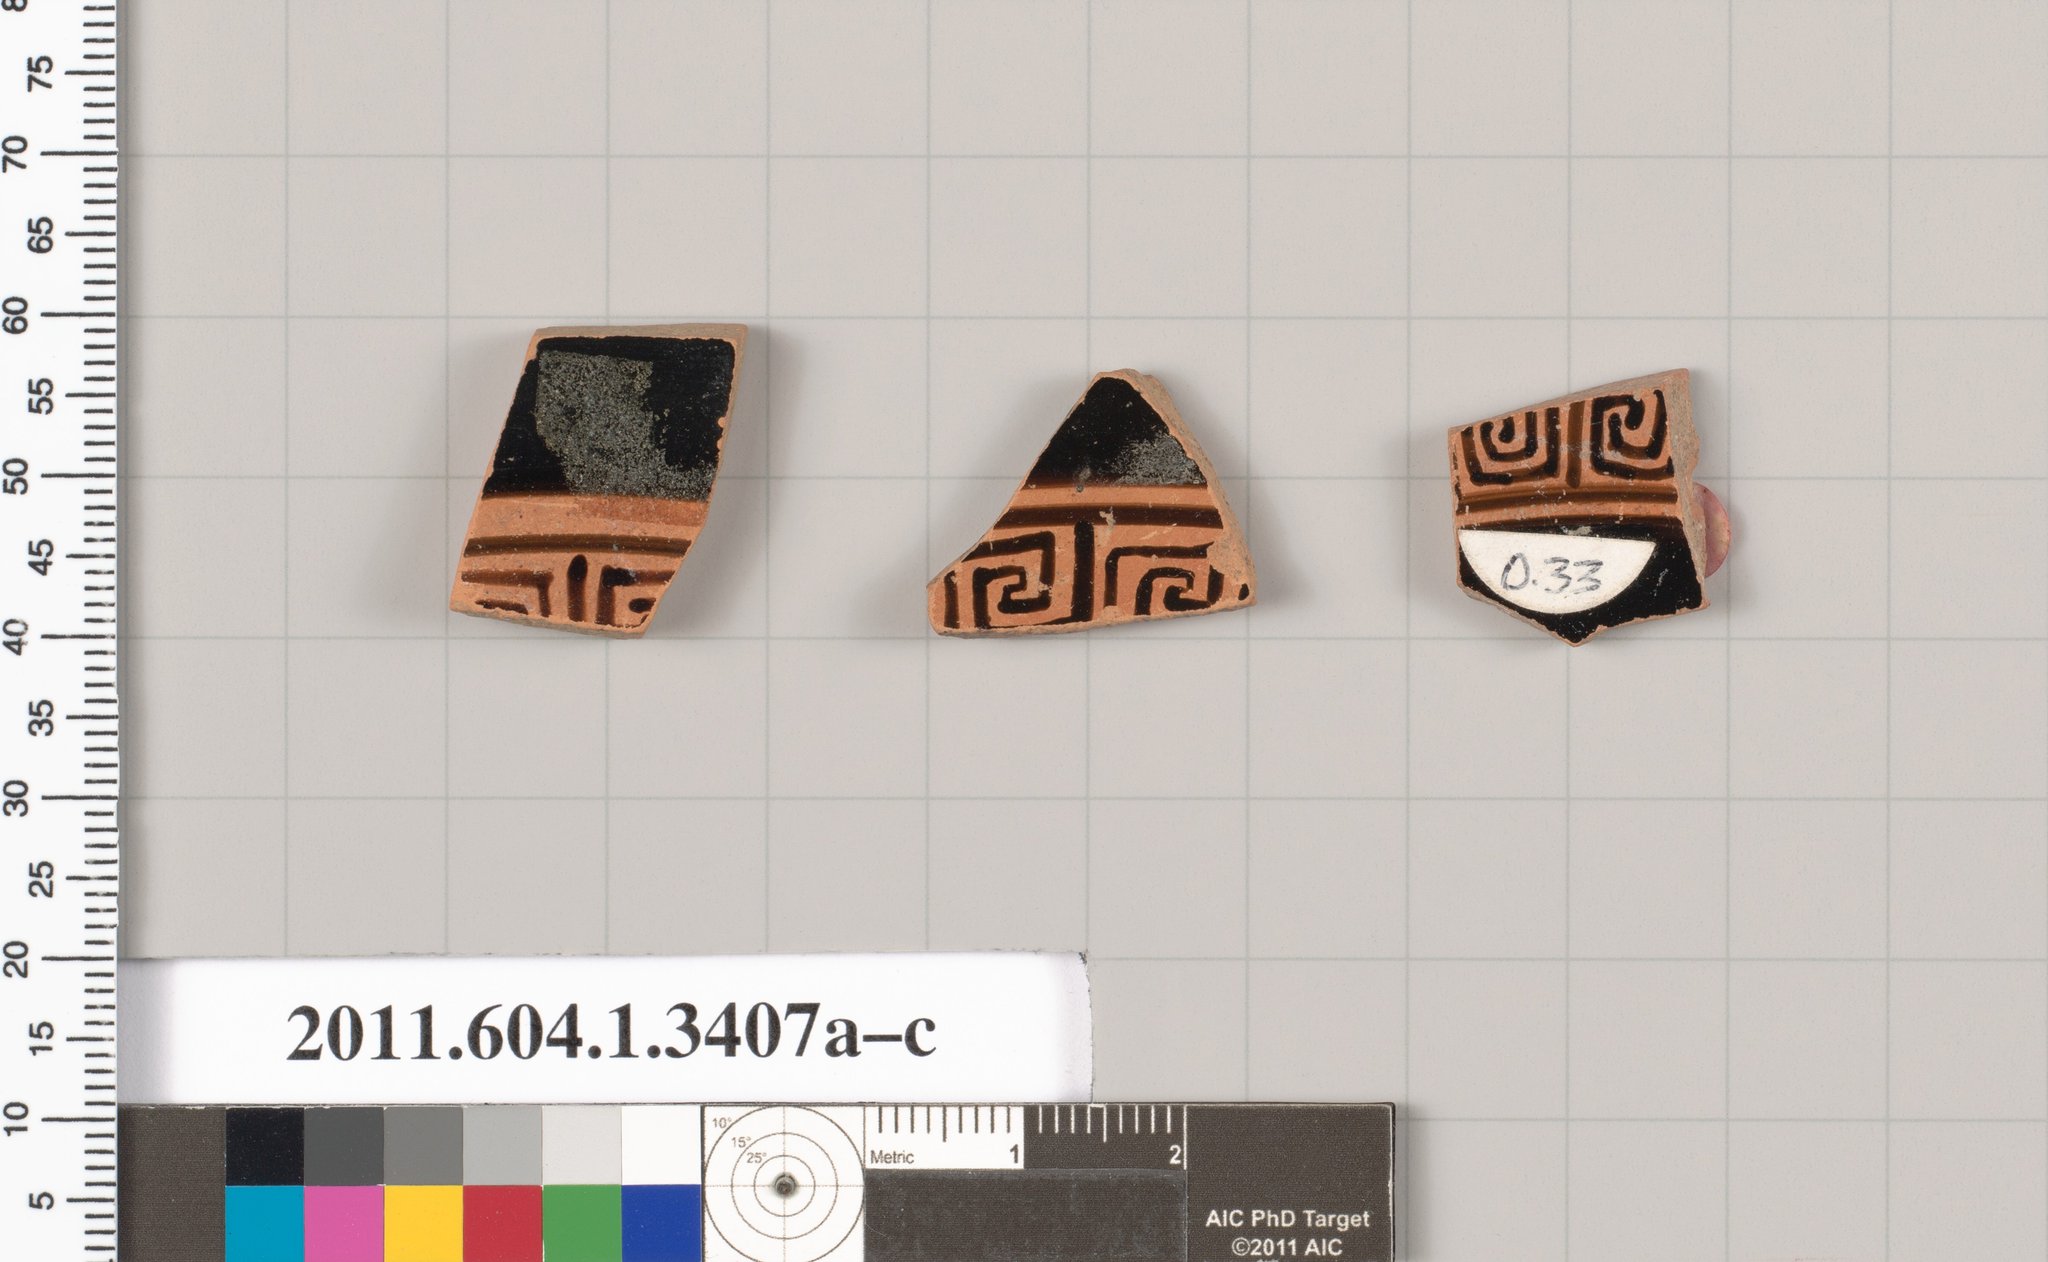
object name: kylix fragment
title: Terracotta fragments of kylikes (drinking cups)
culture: greek, attic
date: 510-470 BCE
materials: terracotta